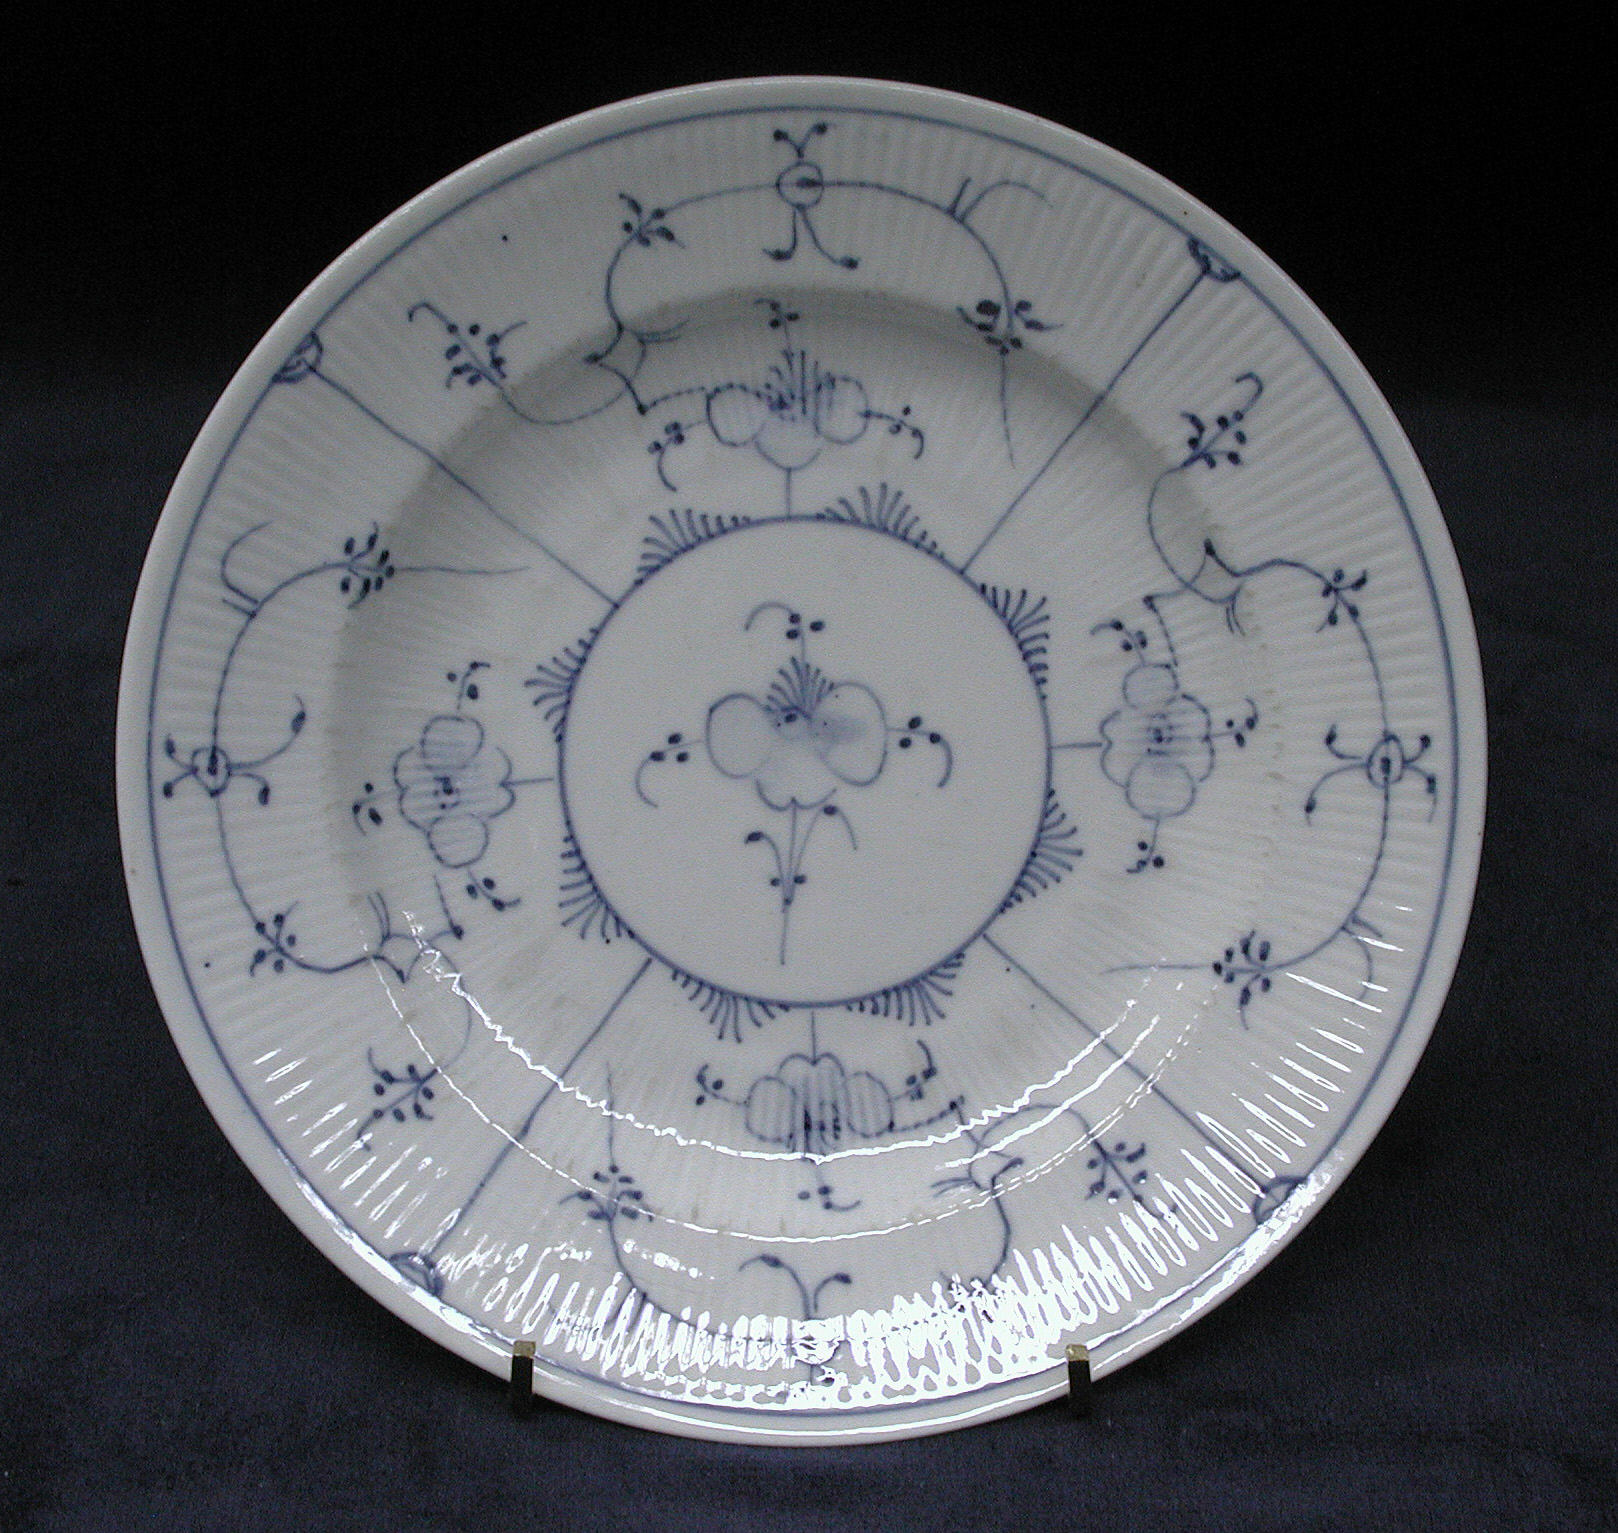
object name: plate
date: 1801-1900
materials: hard paste porcelain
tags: flowers